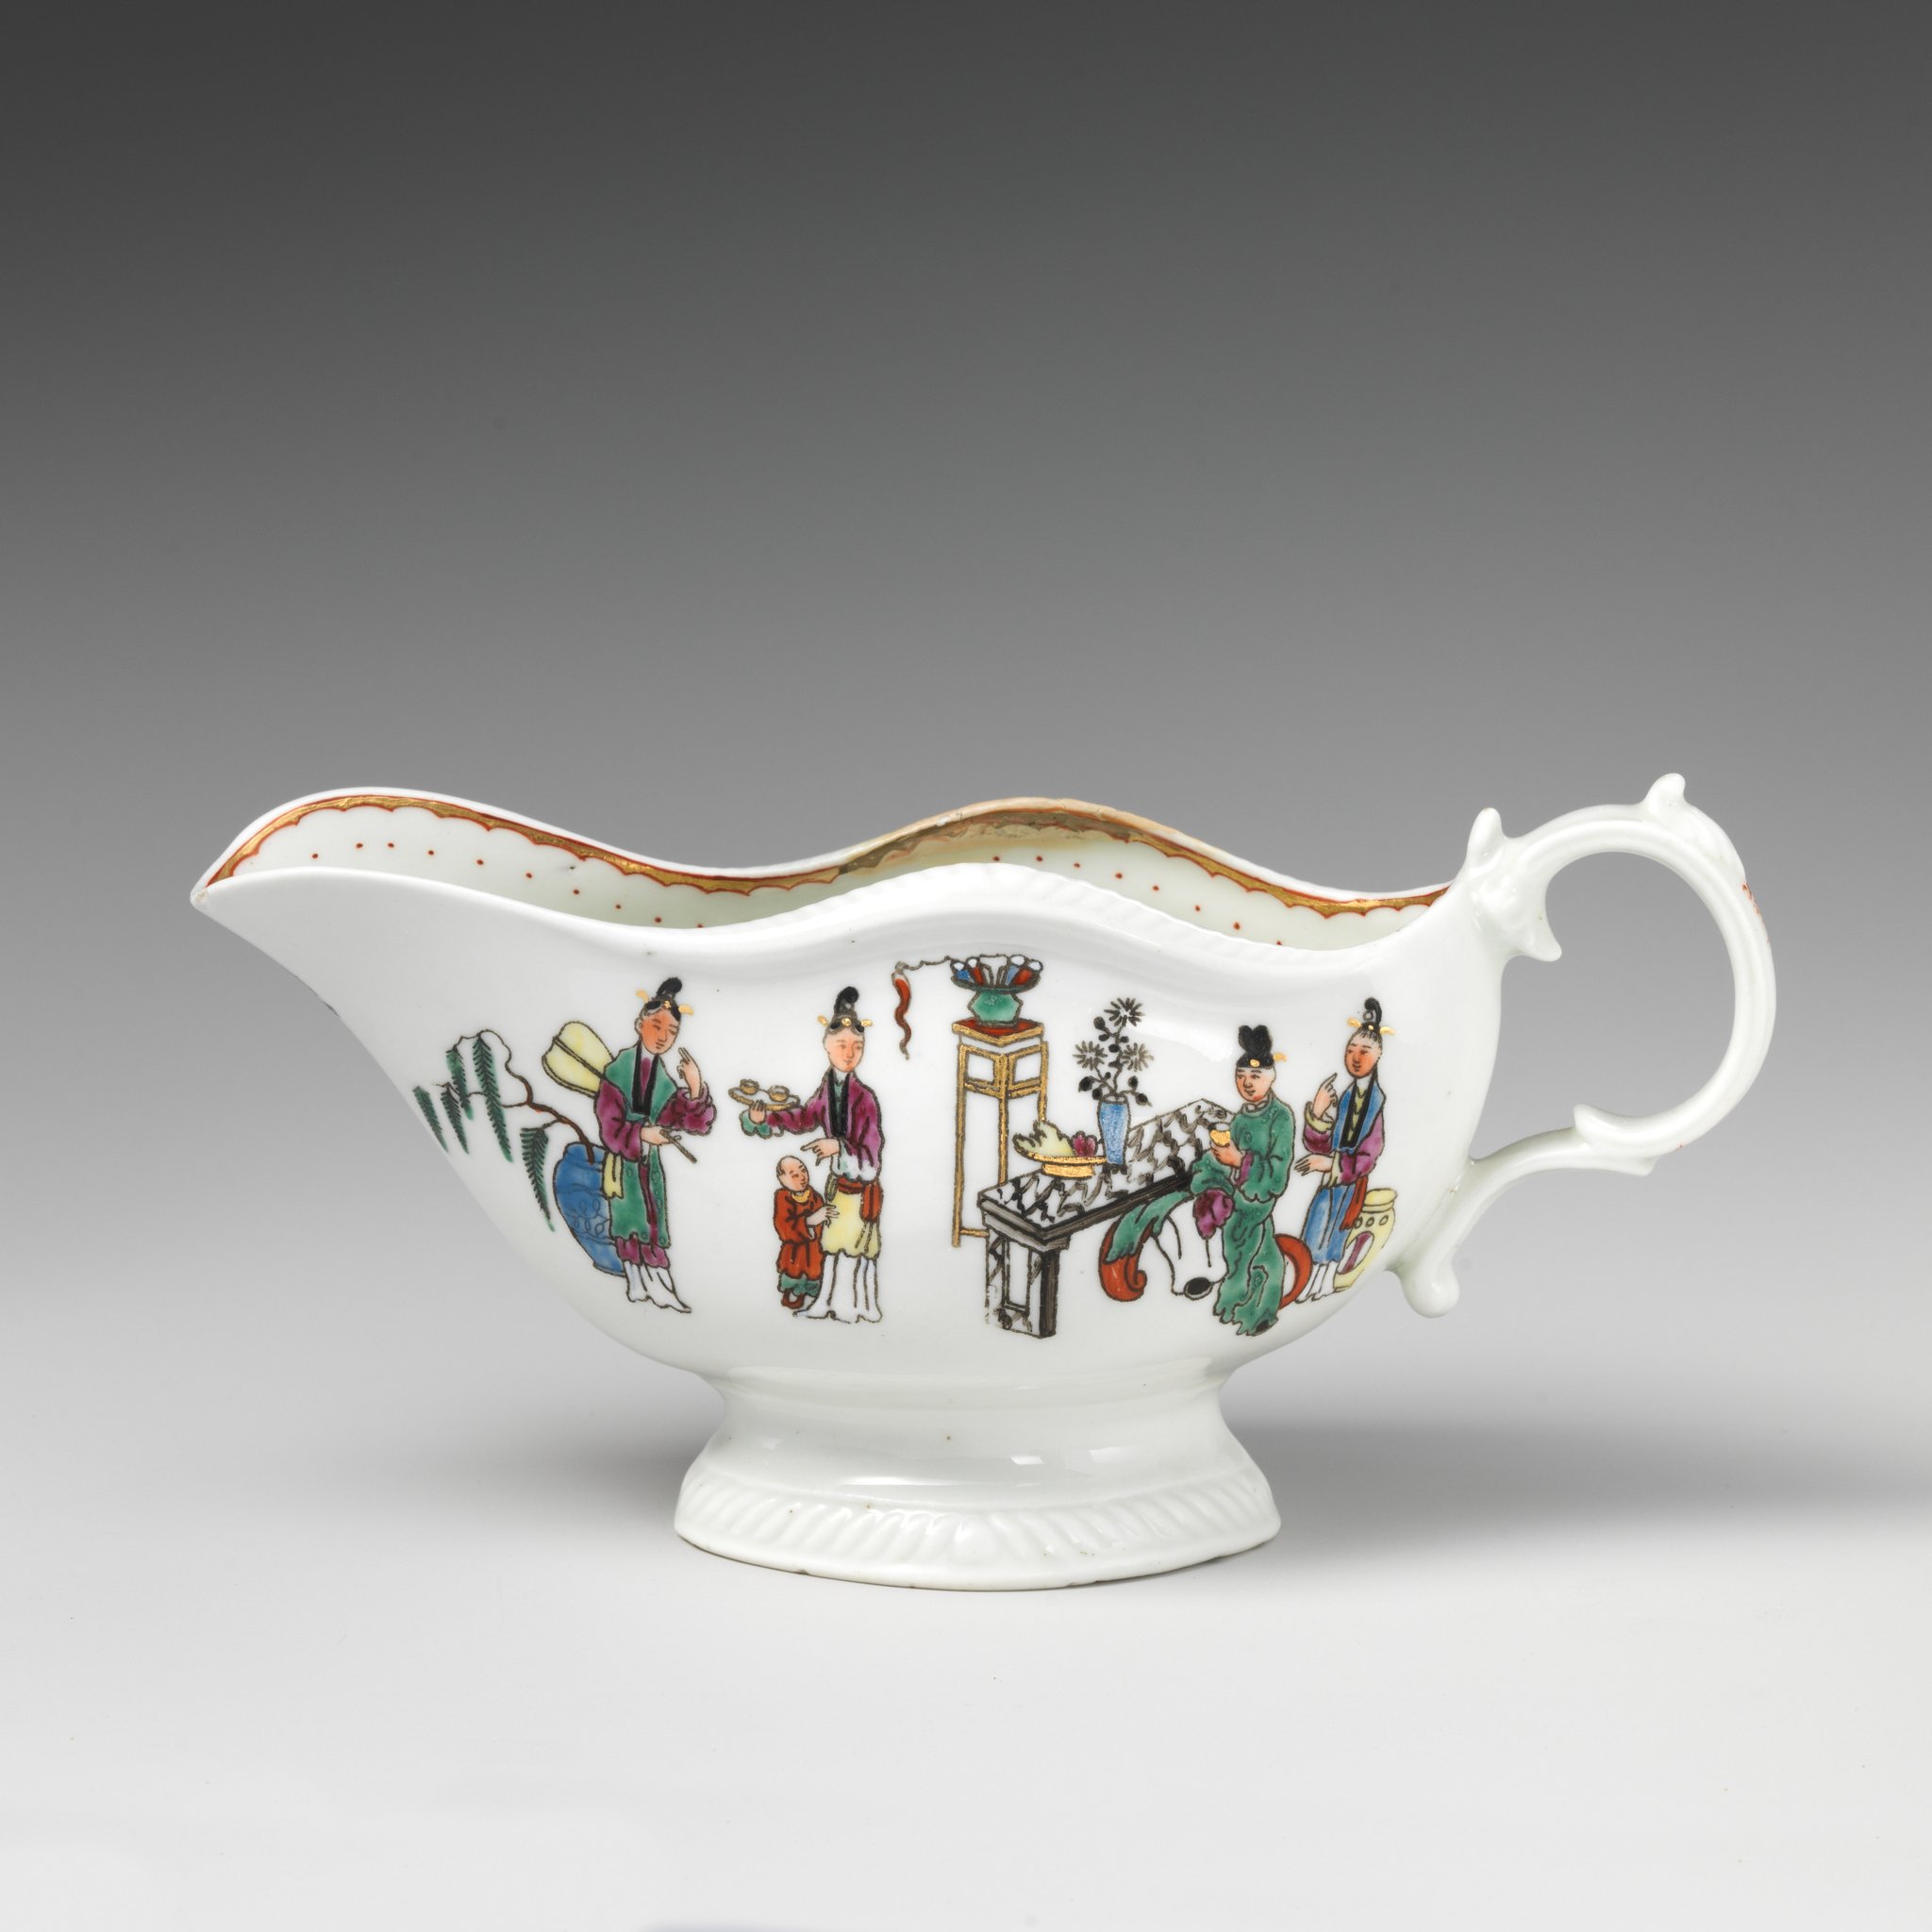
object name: sauceboat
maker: worcester factory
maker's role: factory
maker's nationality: british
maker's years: 1751-2008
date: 1701-1800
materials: soft paste porcelain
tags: human figures,chinoiserie,children